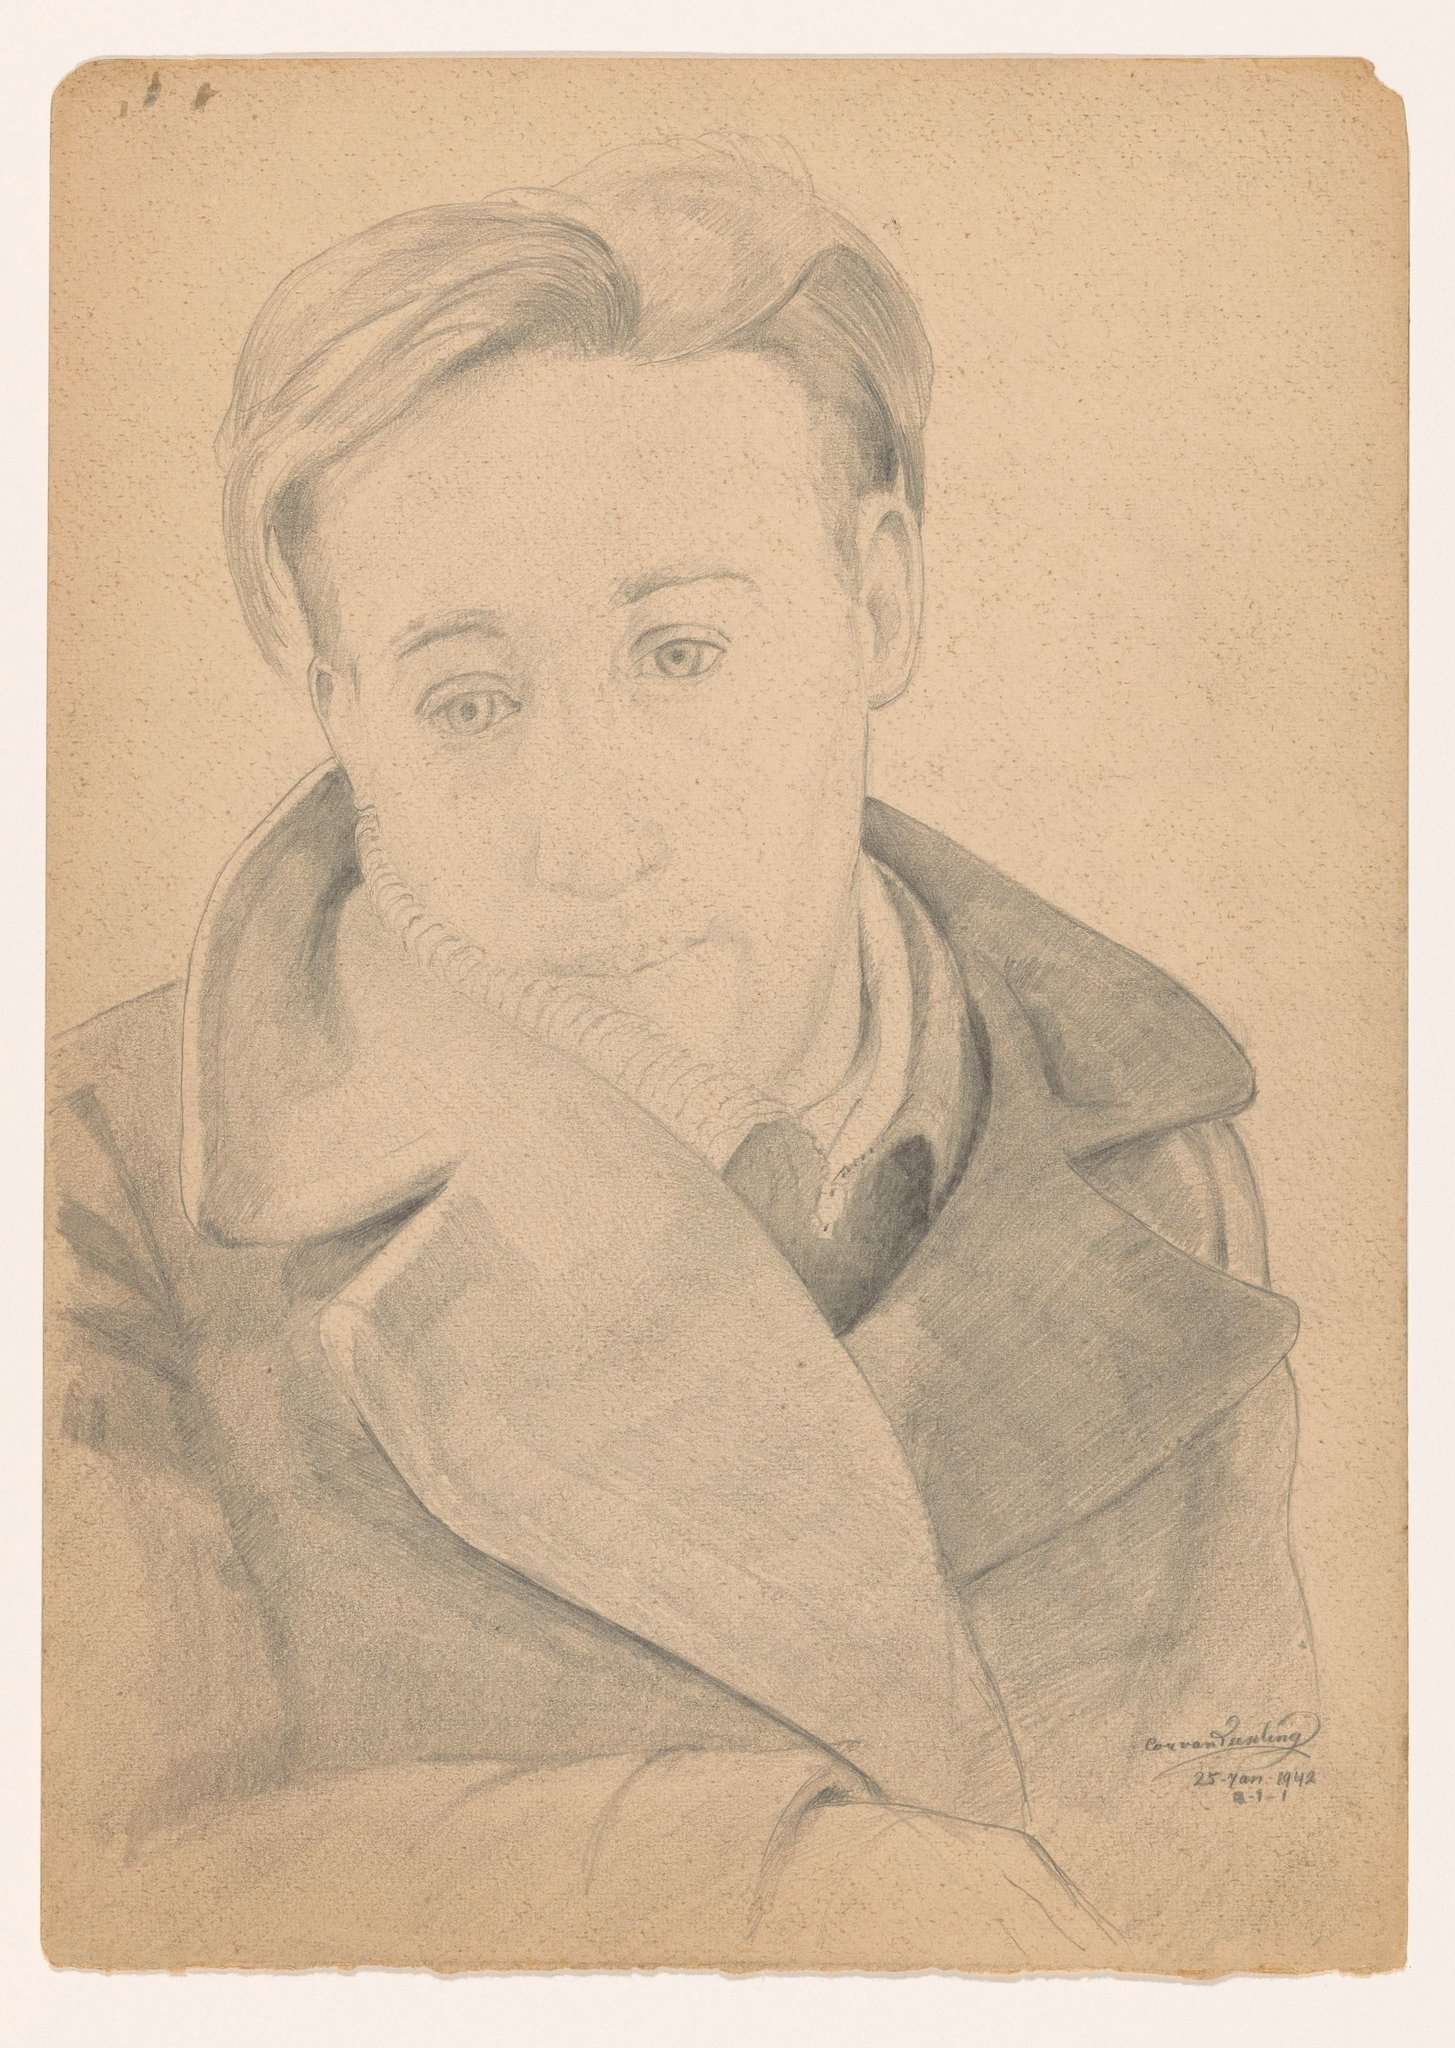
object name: drawing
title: Zelfportret in grote jas: Zollamt Wien: B-1-1, 25 januari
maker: cor van teeseling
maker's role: draughtsman, sculptor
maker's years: 1915-1942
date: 1942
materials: paper, pencil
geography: weteringschans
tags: amsterdam, draughtsman, cor van teeseling, historical persons, prisoner in cell or locked place, portrait, self-portrait of draughtsman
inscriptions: signature and date: ‘Cor van Teeseling / 25 Jan 1942 / B-1-1’, inscription: ‘Zollamt Wien’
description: Zelfportret van Cor van Teeseling in grote jas: Zollamt Wien: gevangenis aan Weteringschans, cel B-1-1, 25 januari. Getekend zelfportret van Cor van Teeseling. Een deel van zijn bovenlijf en zijn rechterarm zijn zichtbaar. Op keerzijde: vakken van een dambord.